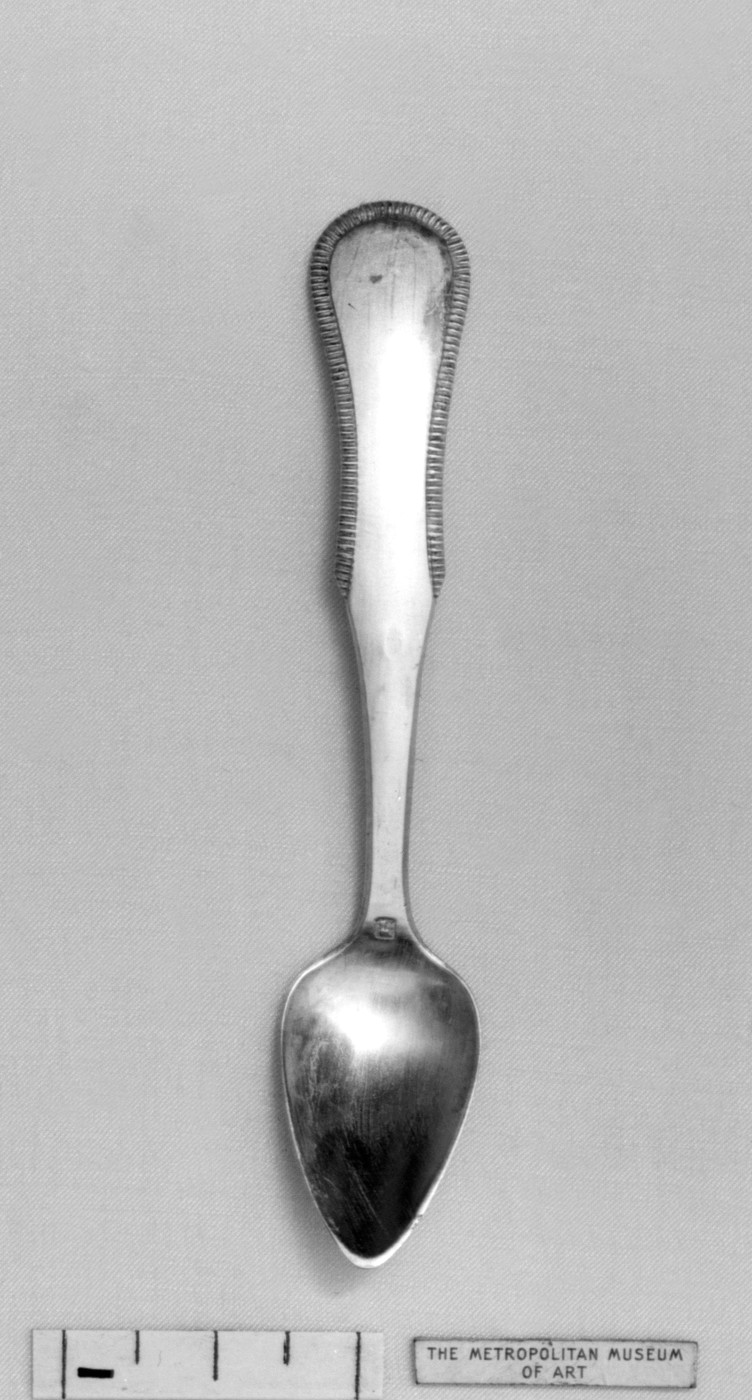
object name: toy spoon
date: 1801-1833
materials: silver